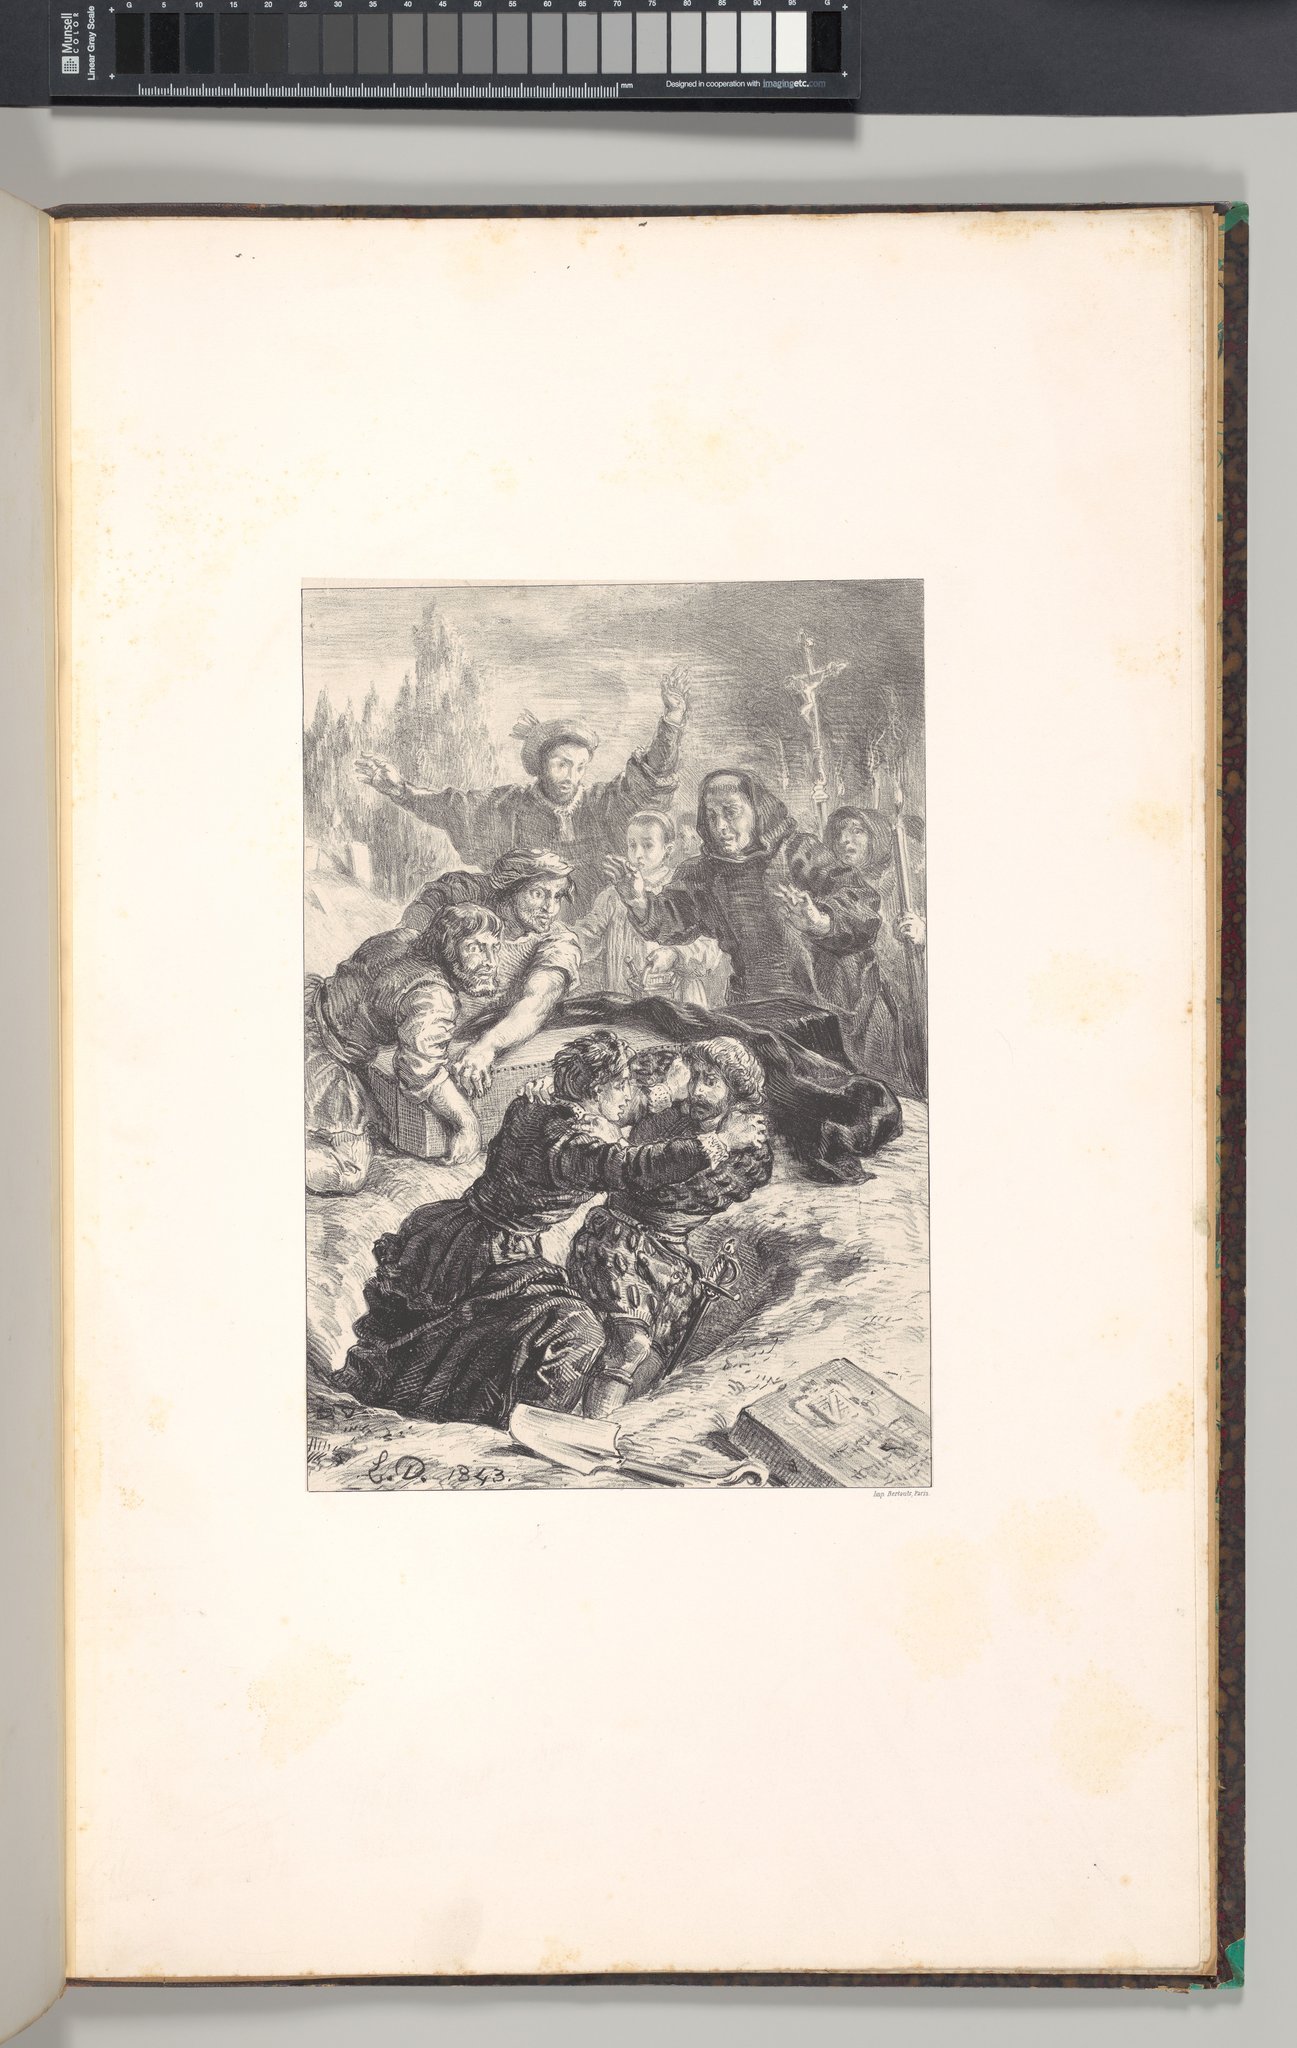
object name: book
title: Hamlet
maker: eugène delacroix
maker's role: artist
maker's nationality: french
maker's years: 1798-1863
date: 1864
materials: ink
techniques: lithograph, pen